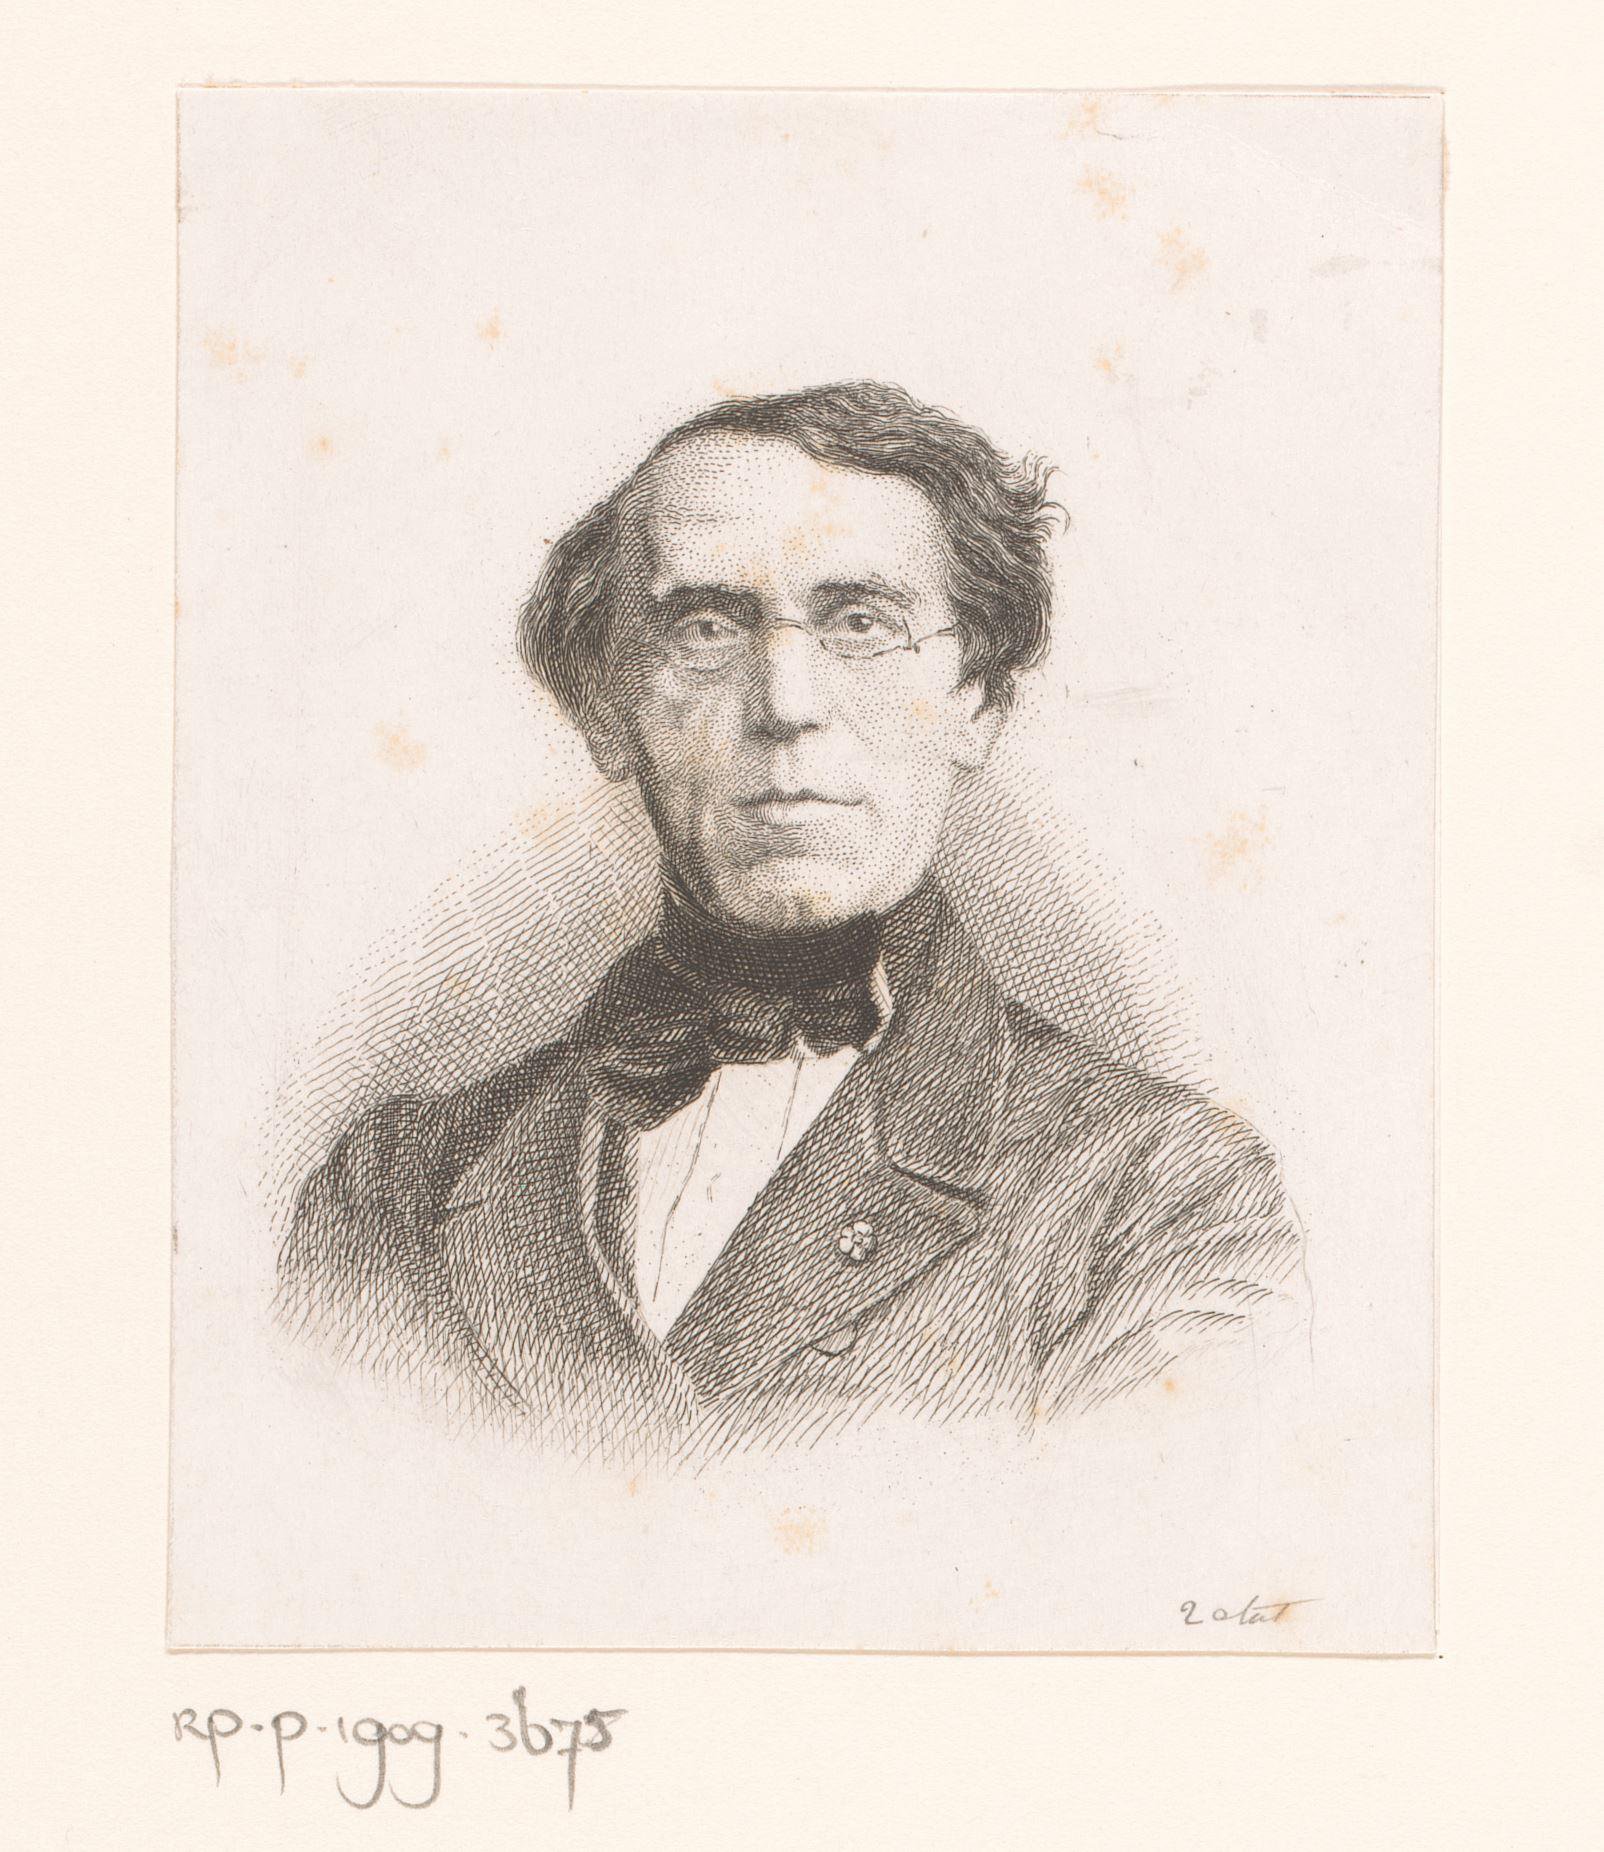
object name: print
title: Portret van een onbekende man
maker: auguste danse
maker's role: print maker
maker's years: 1829-1929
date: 1876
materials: paper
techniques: etching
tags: eyeglasses, spectacles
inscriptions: collector's mark: Lugt 2228, annotation: ‘2 etat’